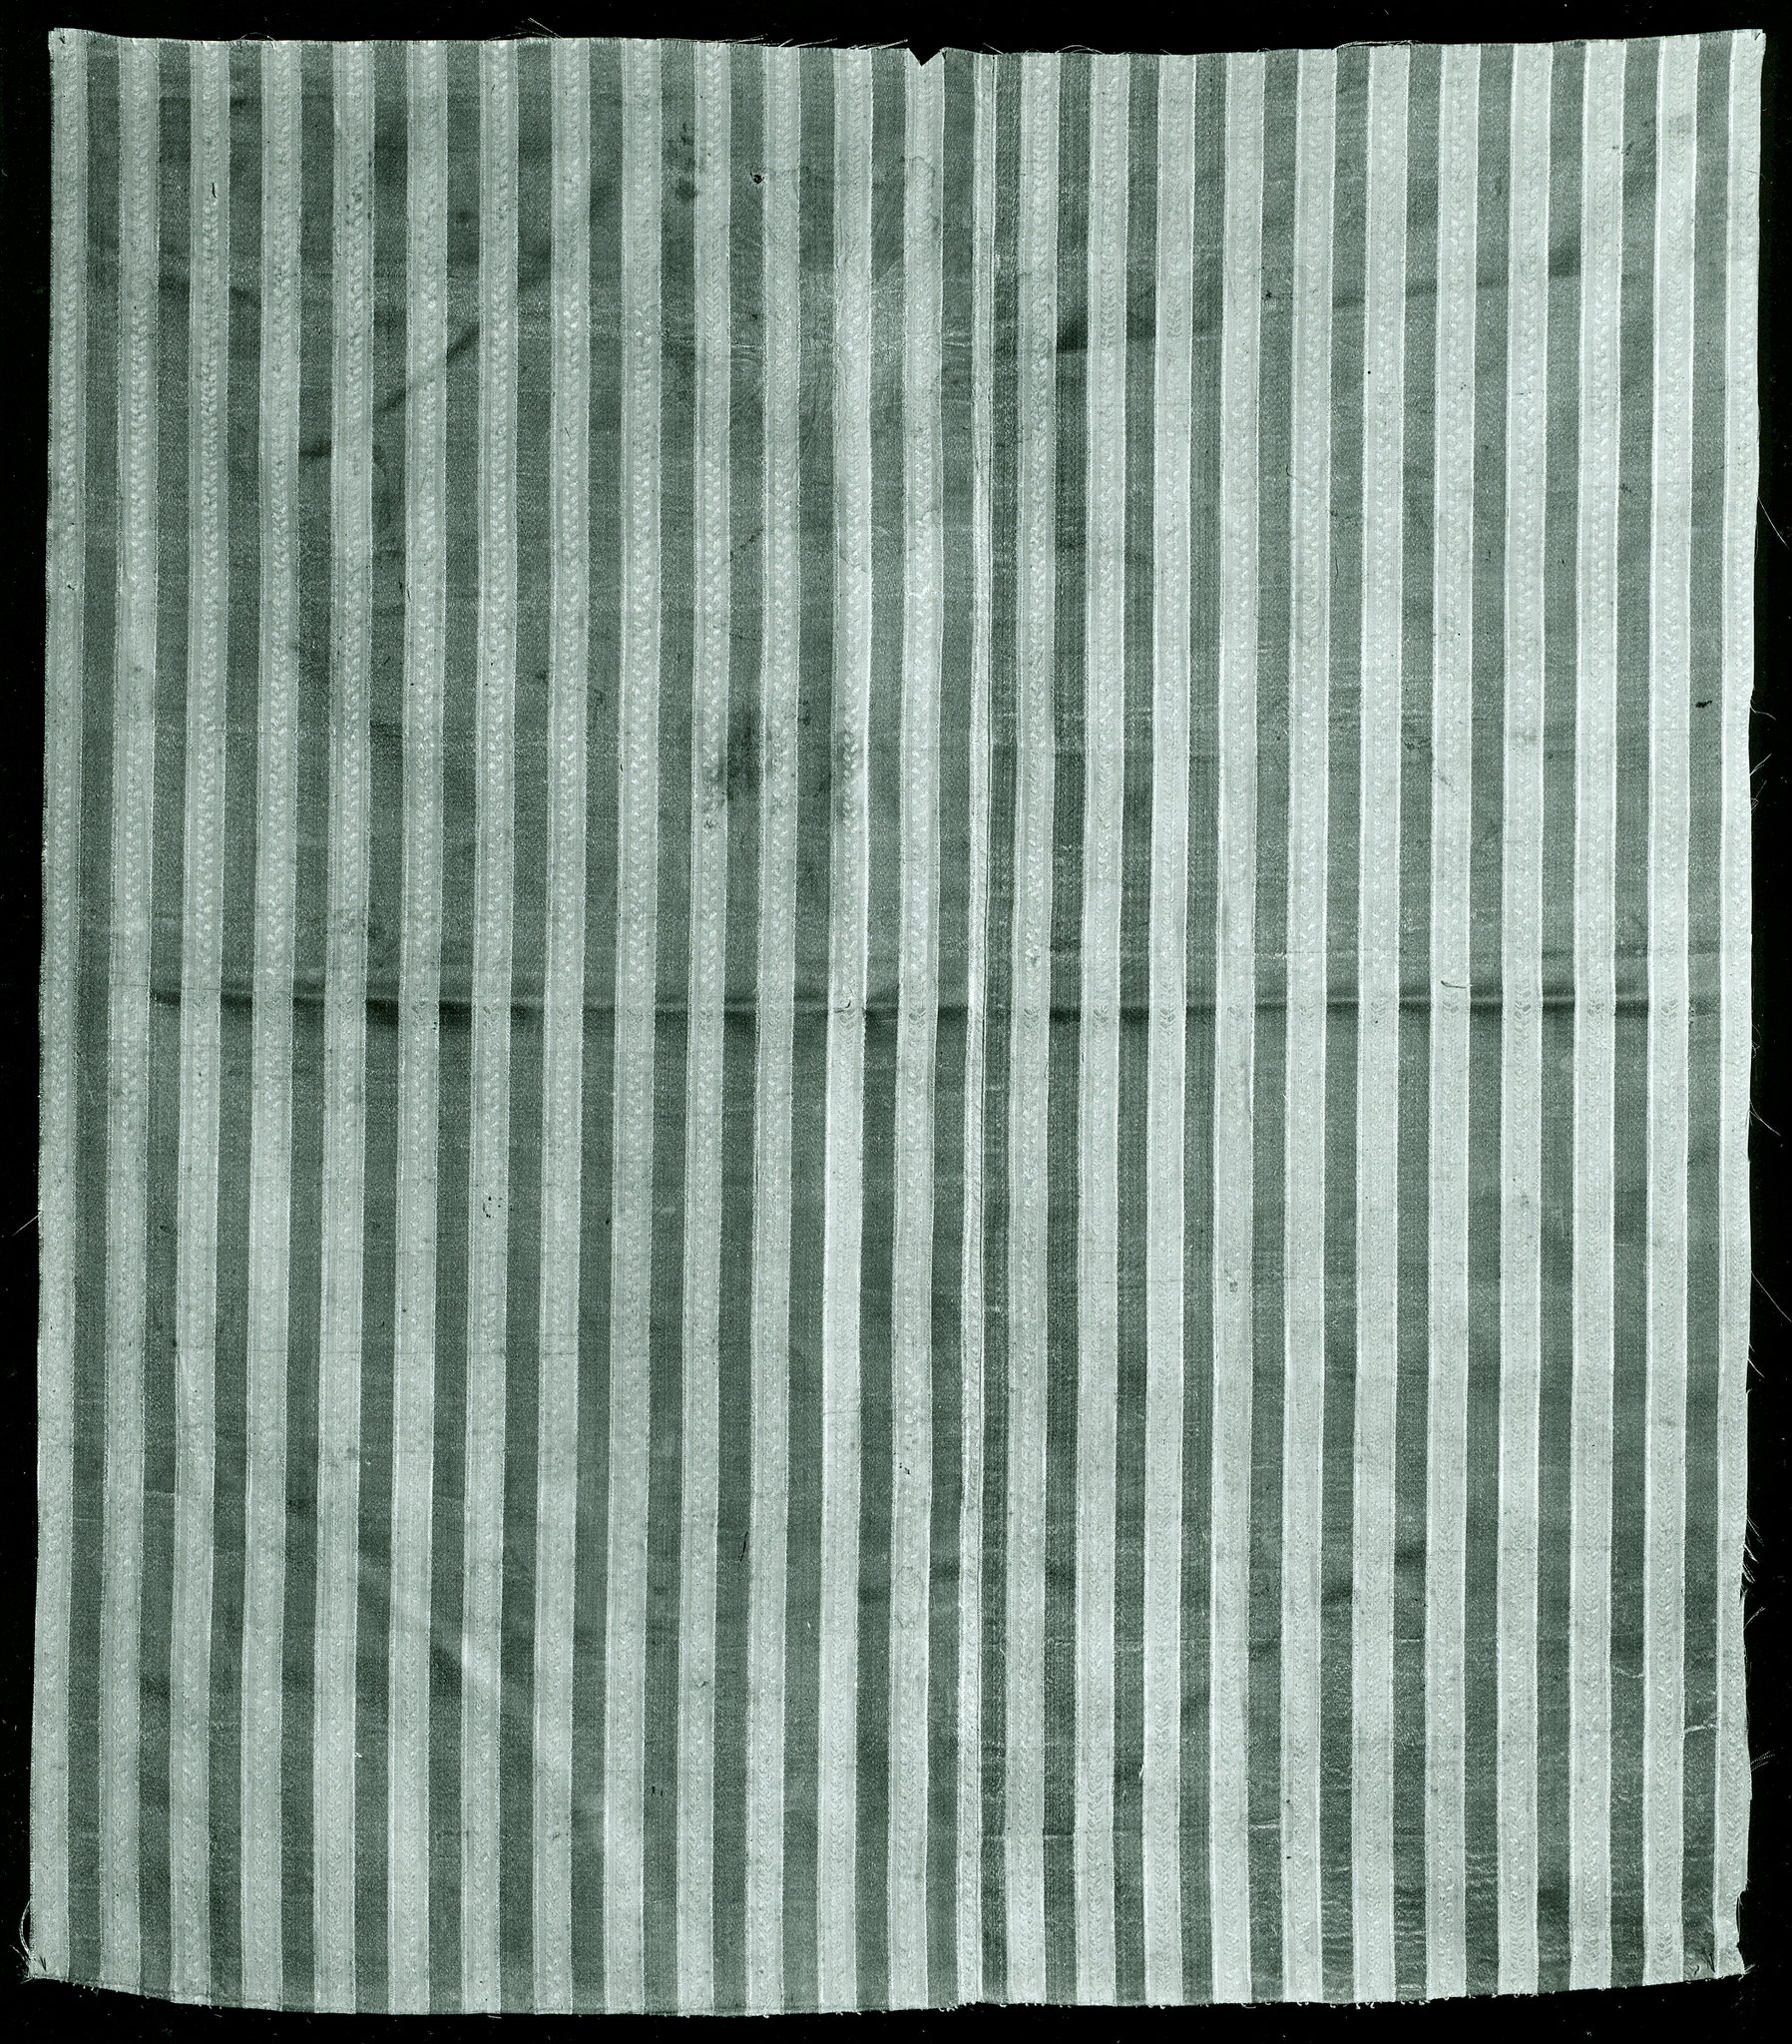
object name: textile panel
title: Panel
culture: spanish or valencian or talavera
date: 1767-1800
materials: silk